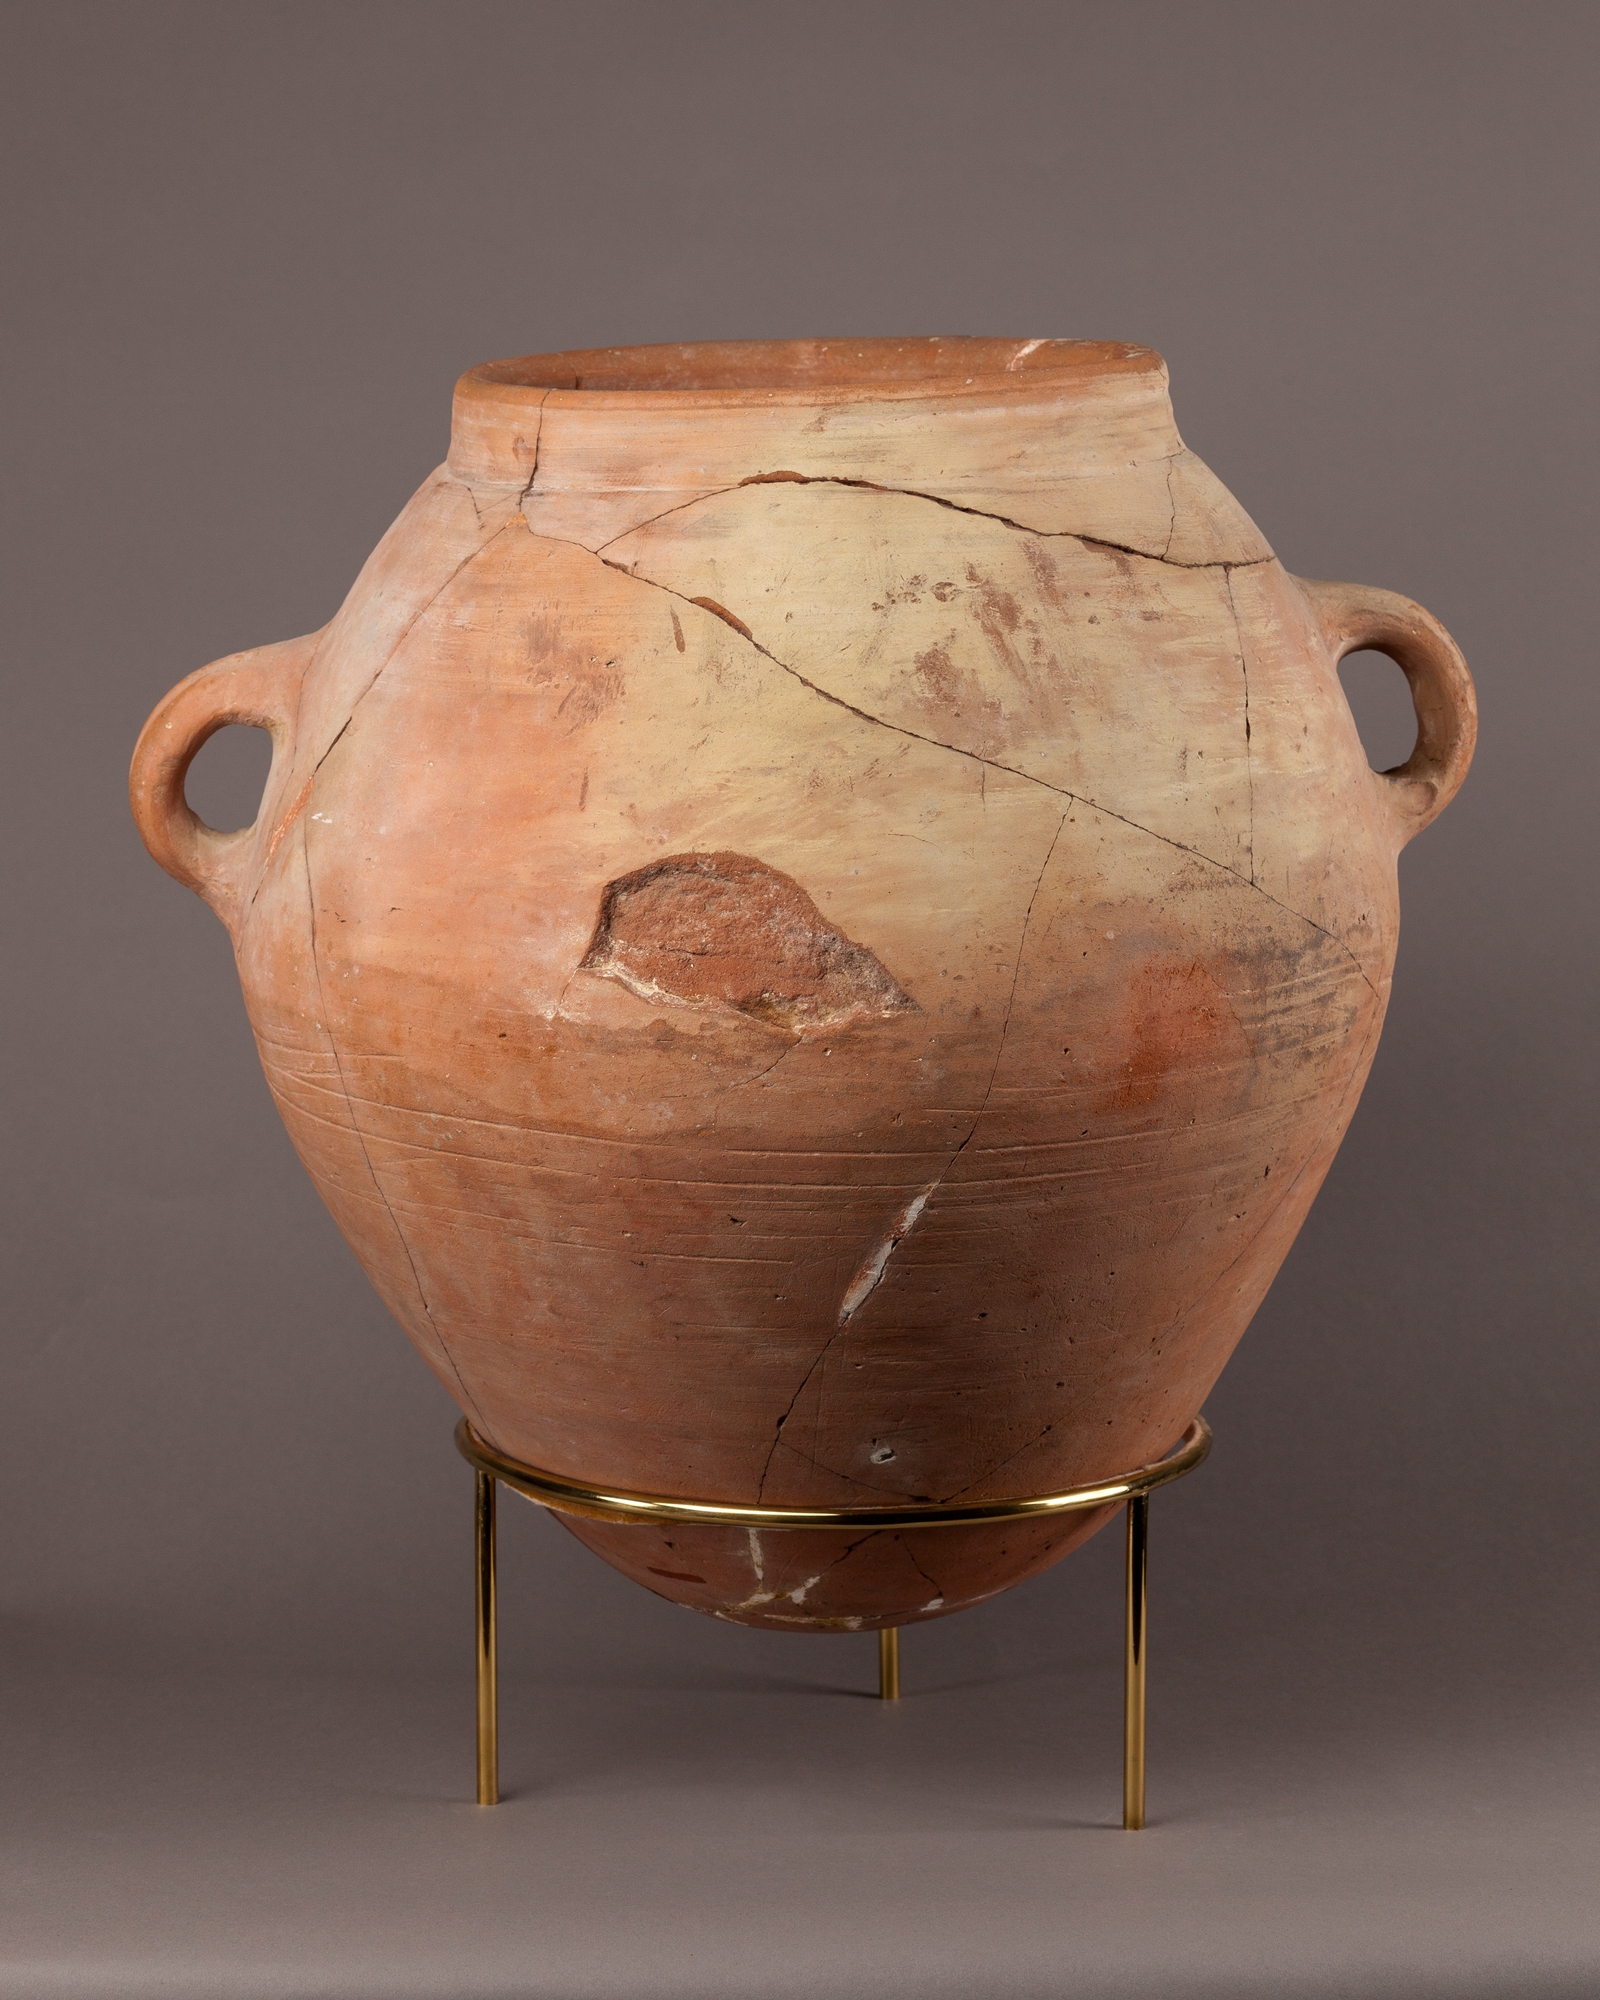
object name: jar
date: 1295-1070 BCE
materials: pottery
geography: egypt